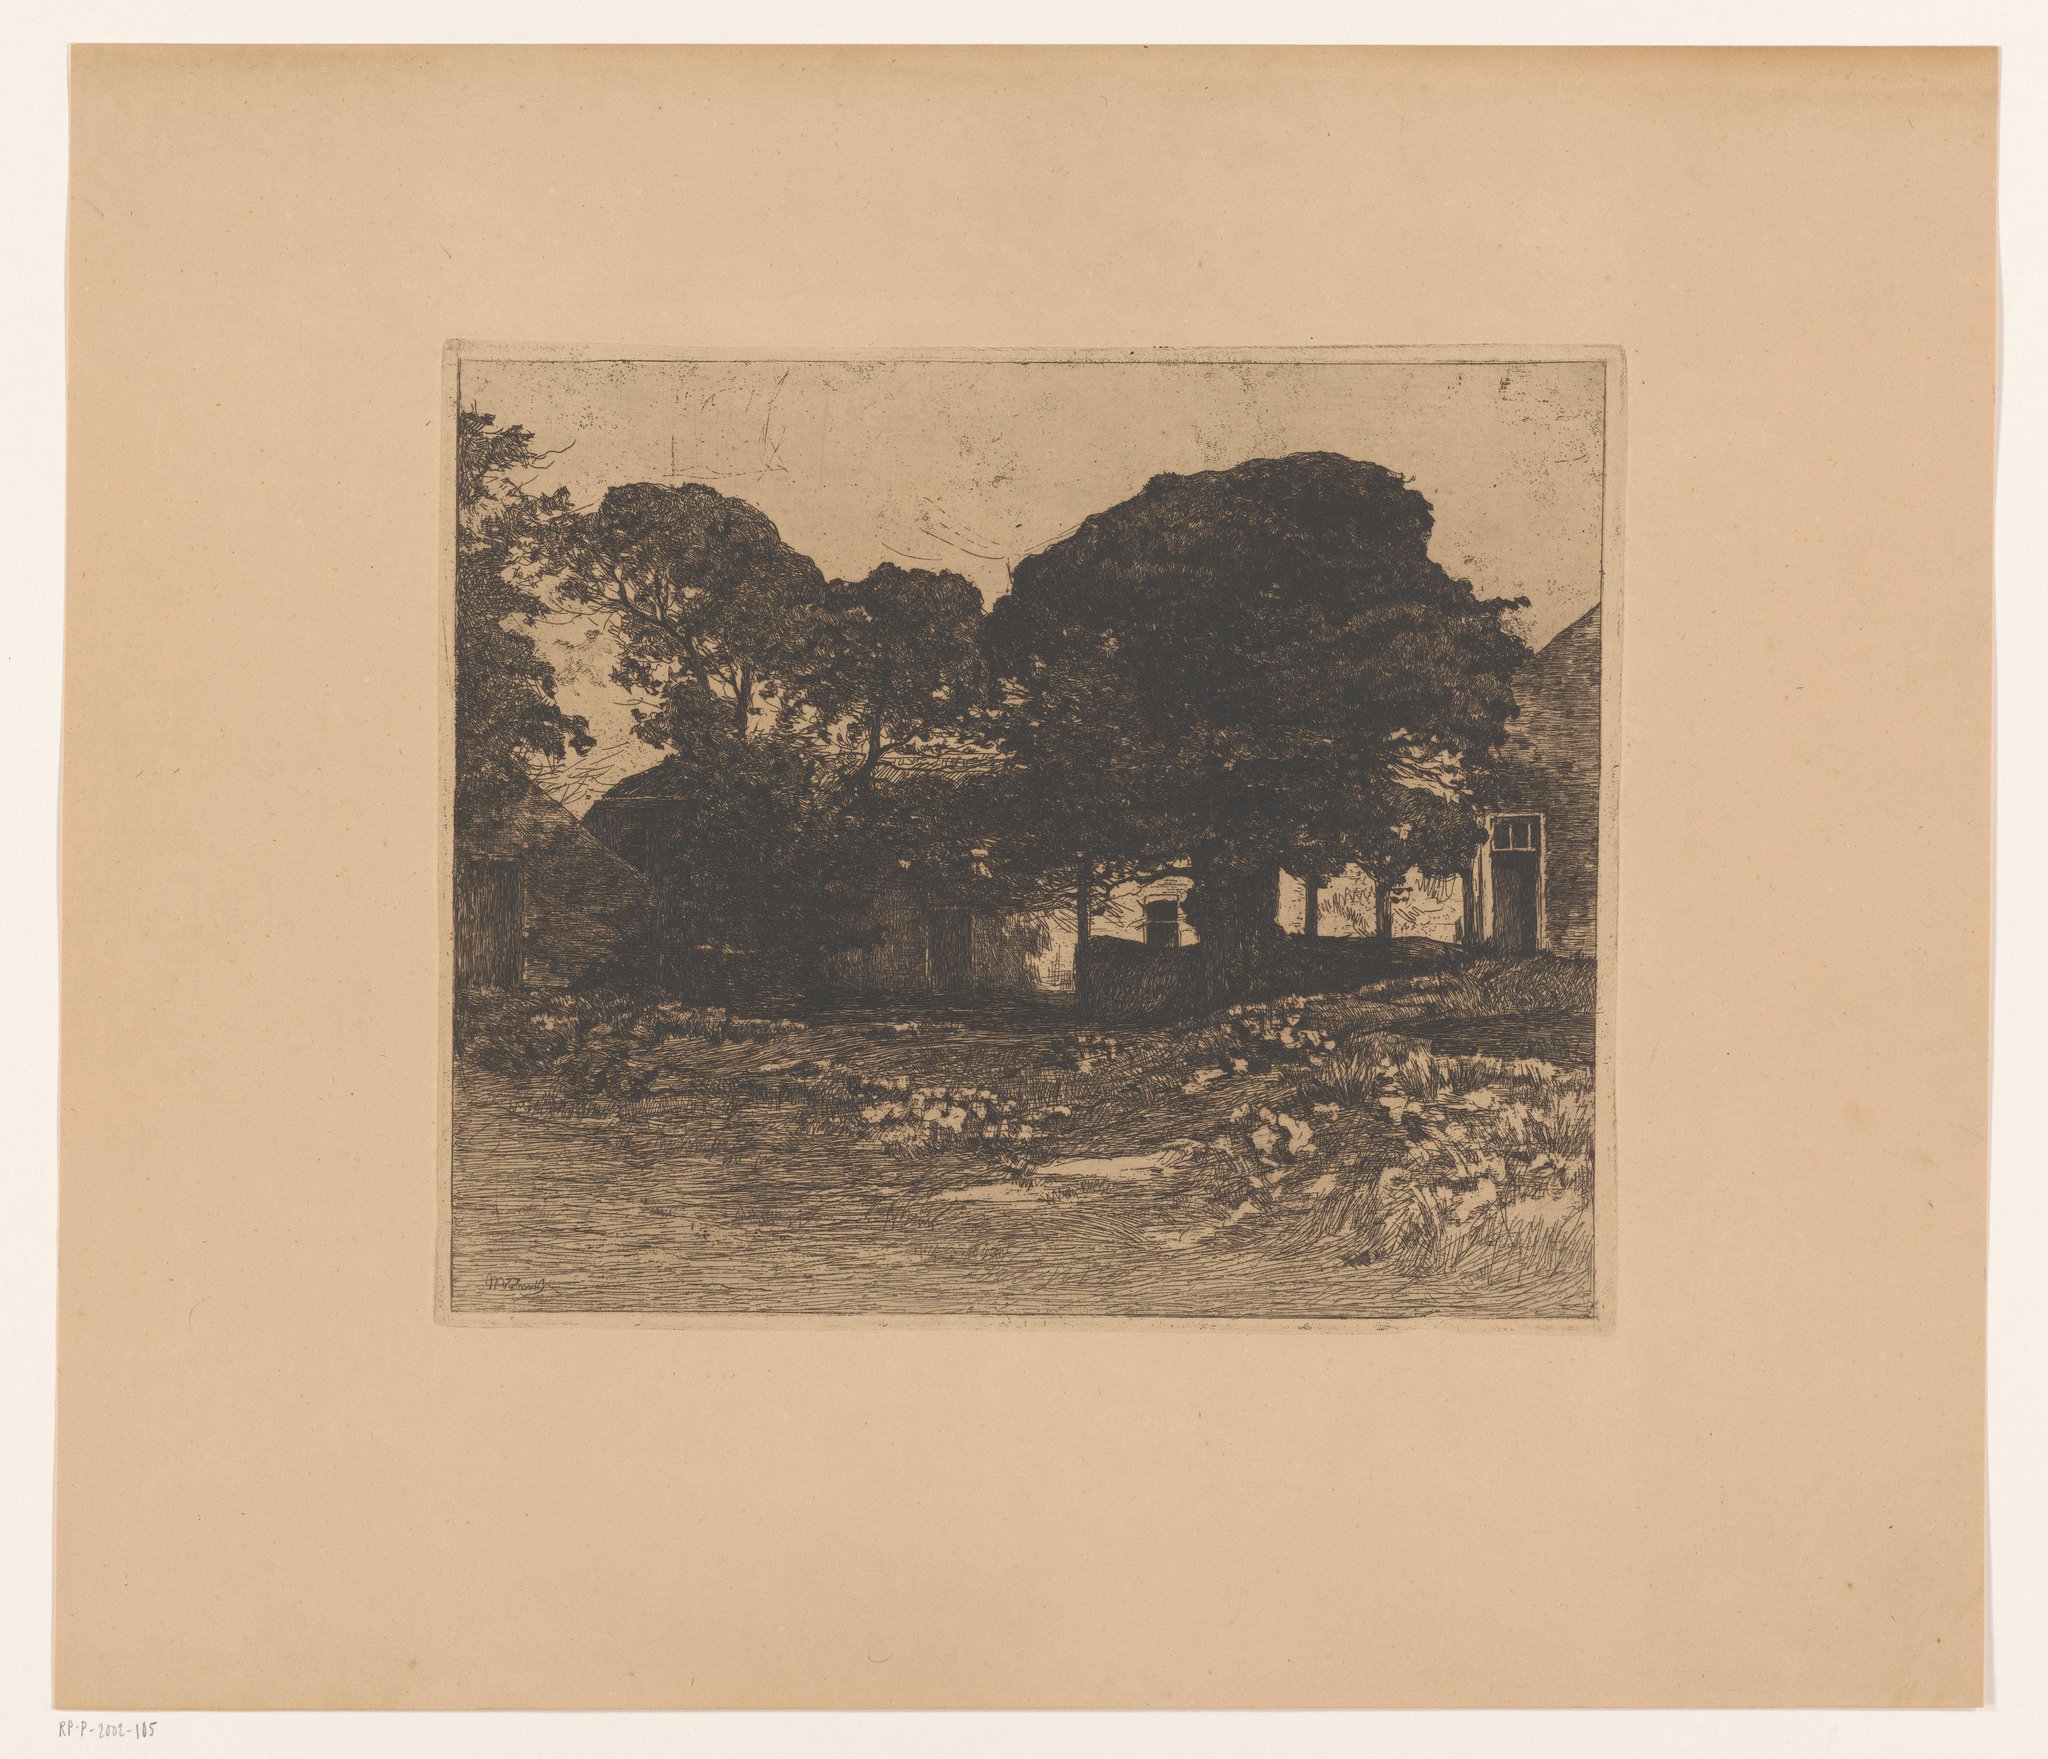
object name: print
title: Landschap met boerderij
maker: willem de zwart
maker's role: draughtsman, painter, print maker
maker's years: 1862-1931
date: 1872-1931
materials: paper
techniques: etching, intaglio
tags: farm or solitary house in landscape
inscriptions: collector's mark: Lugt 2228, collector's mark: Lugt 2760